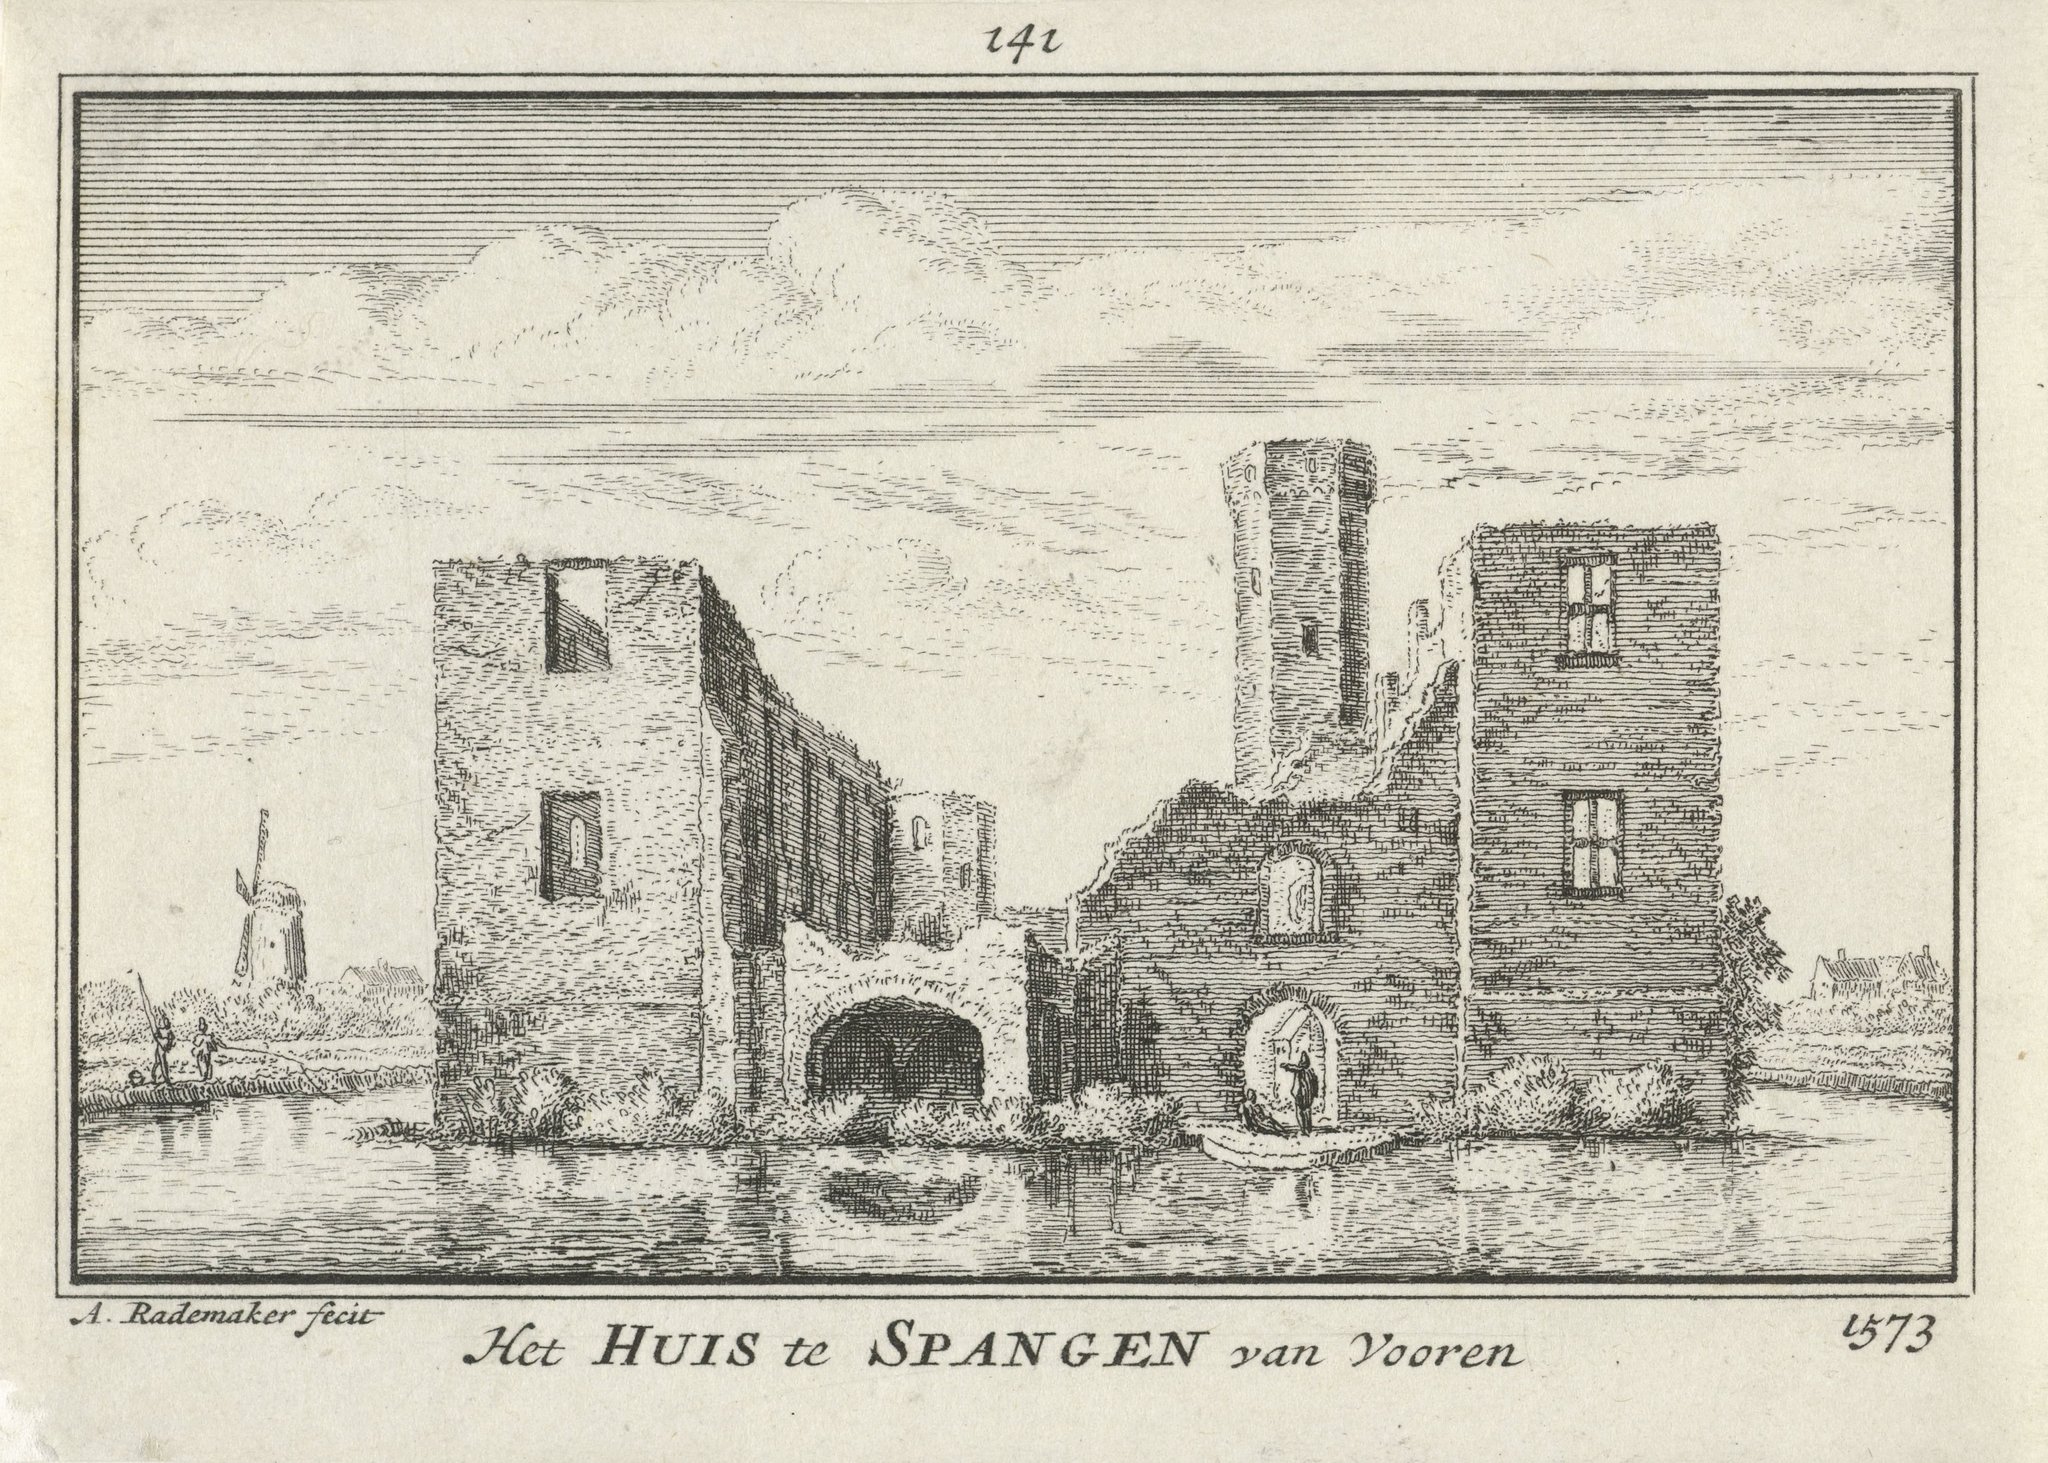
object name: print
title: Het Huis te Spangen van vooren 1573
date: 1727-1733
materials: paper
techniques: etching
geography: amsterdam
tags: rowing-boat, canoe, etc., windmill, ruin of a dwelling, house, castle, etc.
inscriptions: collector's mark: Lugt 2228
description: Gezicht op de voorkant van de ruïne van het in 1572 verwoeste Kasteel Spangen, in de situatie omstreeks 1573. Het kasteel werd naar het riviertje de Spangen vernoemd. Links een molen en twee vissers en op de voorgrond een roeiboot met twee figuren.